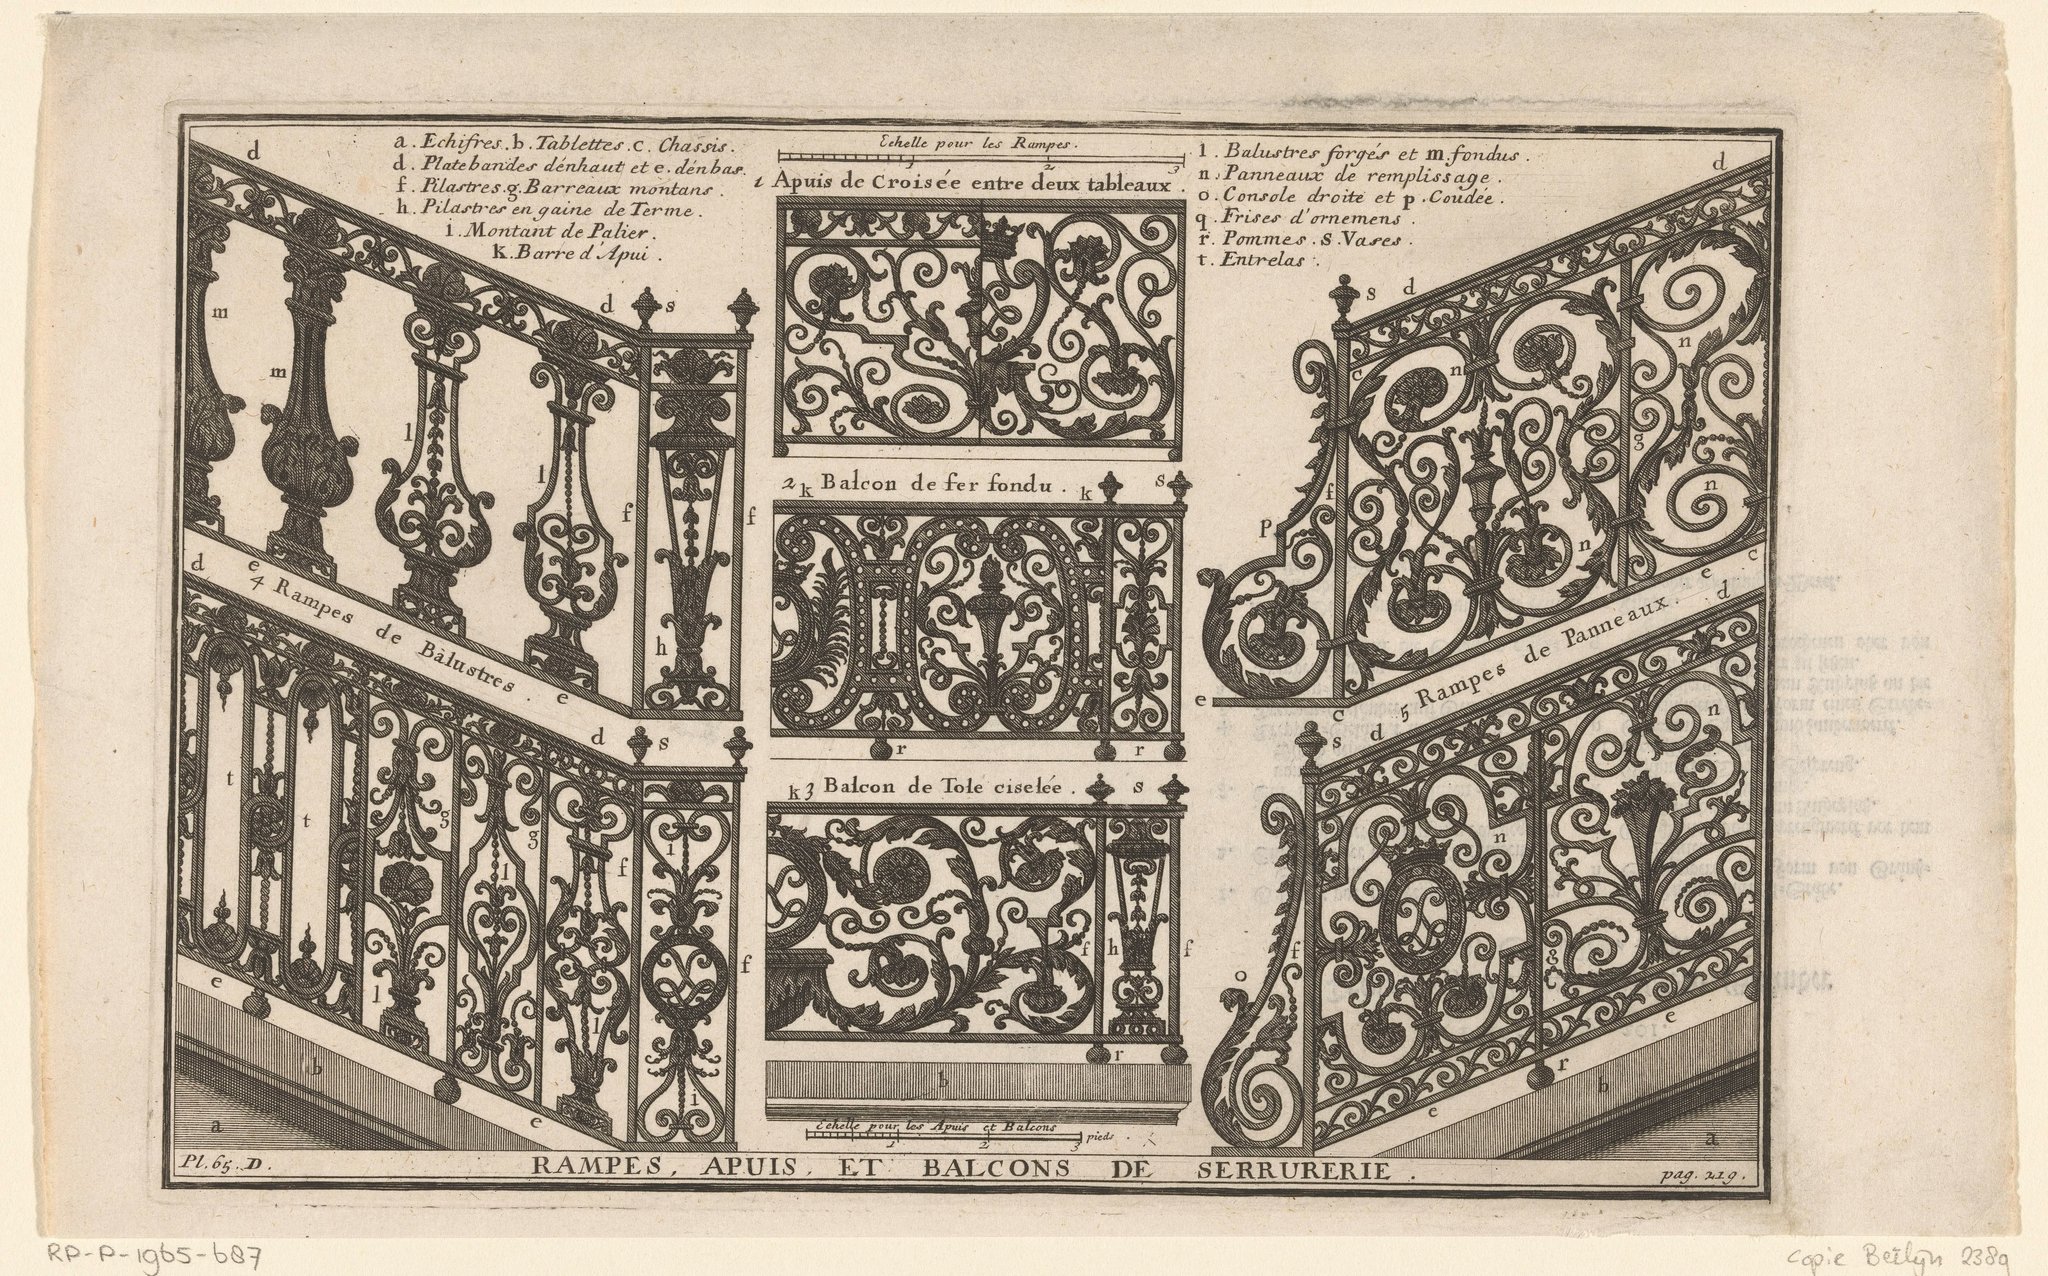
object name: ornament print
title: Cours D'Architecture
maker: Anonymous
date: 1691-1750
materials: paper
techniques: engraving, etching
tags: staircase, balcony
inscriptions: collector's mark: Lugt 2760, collector's mark: Lugt 2228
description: Pagina 219, plaat 65D uit: Aviler, Charles Augustin d'. Cours d'architecture (...). Parijs: s.n., [1691-1750].